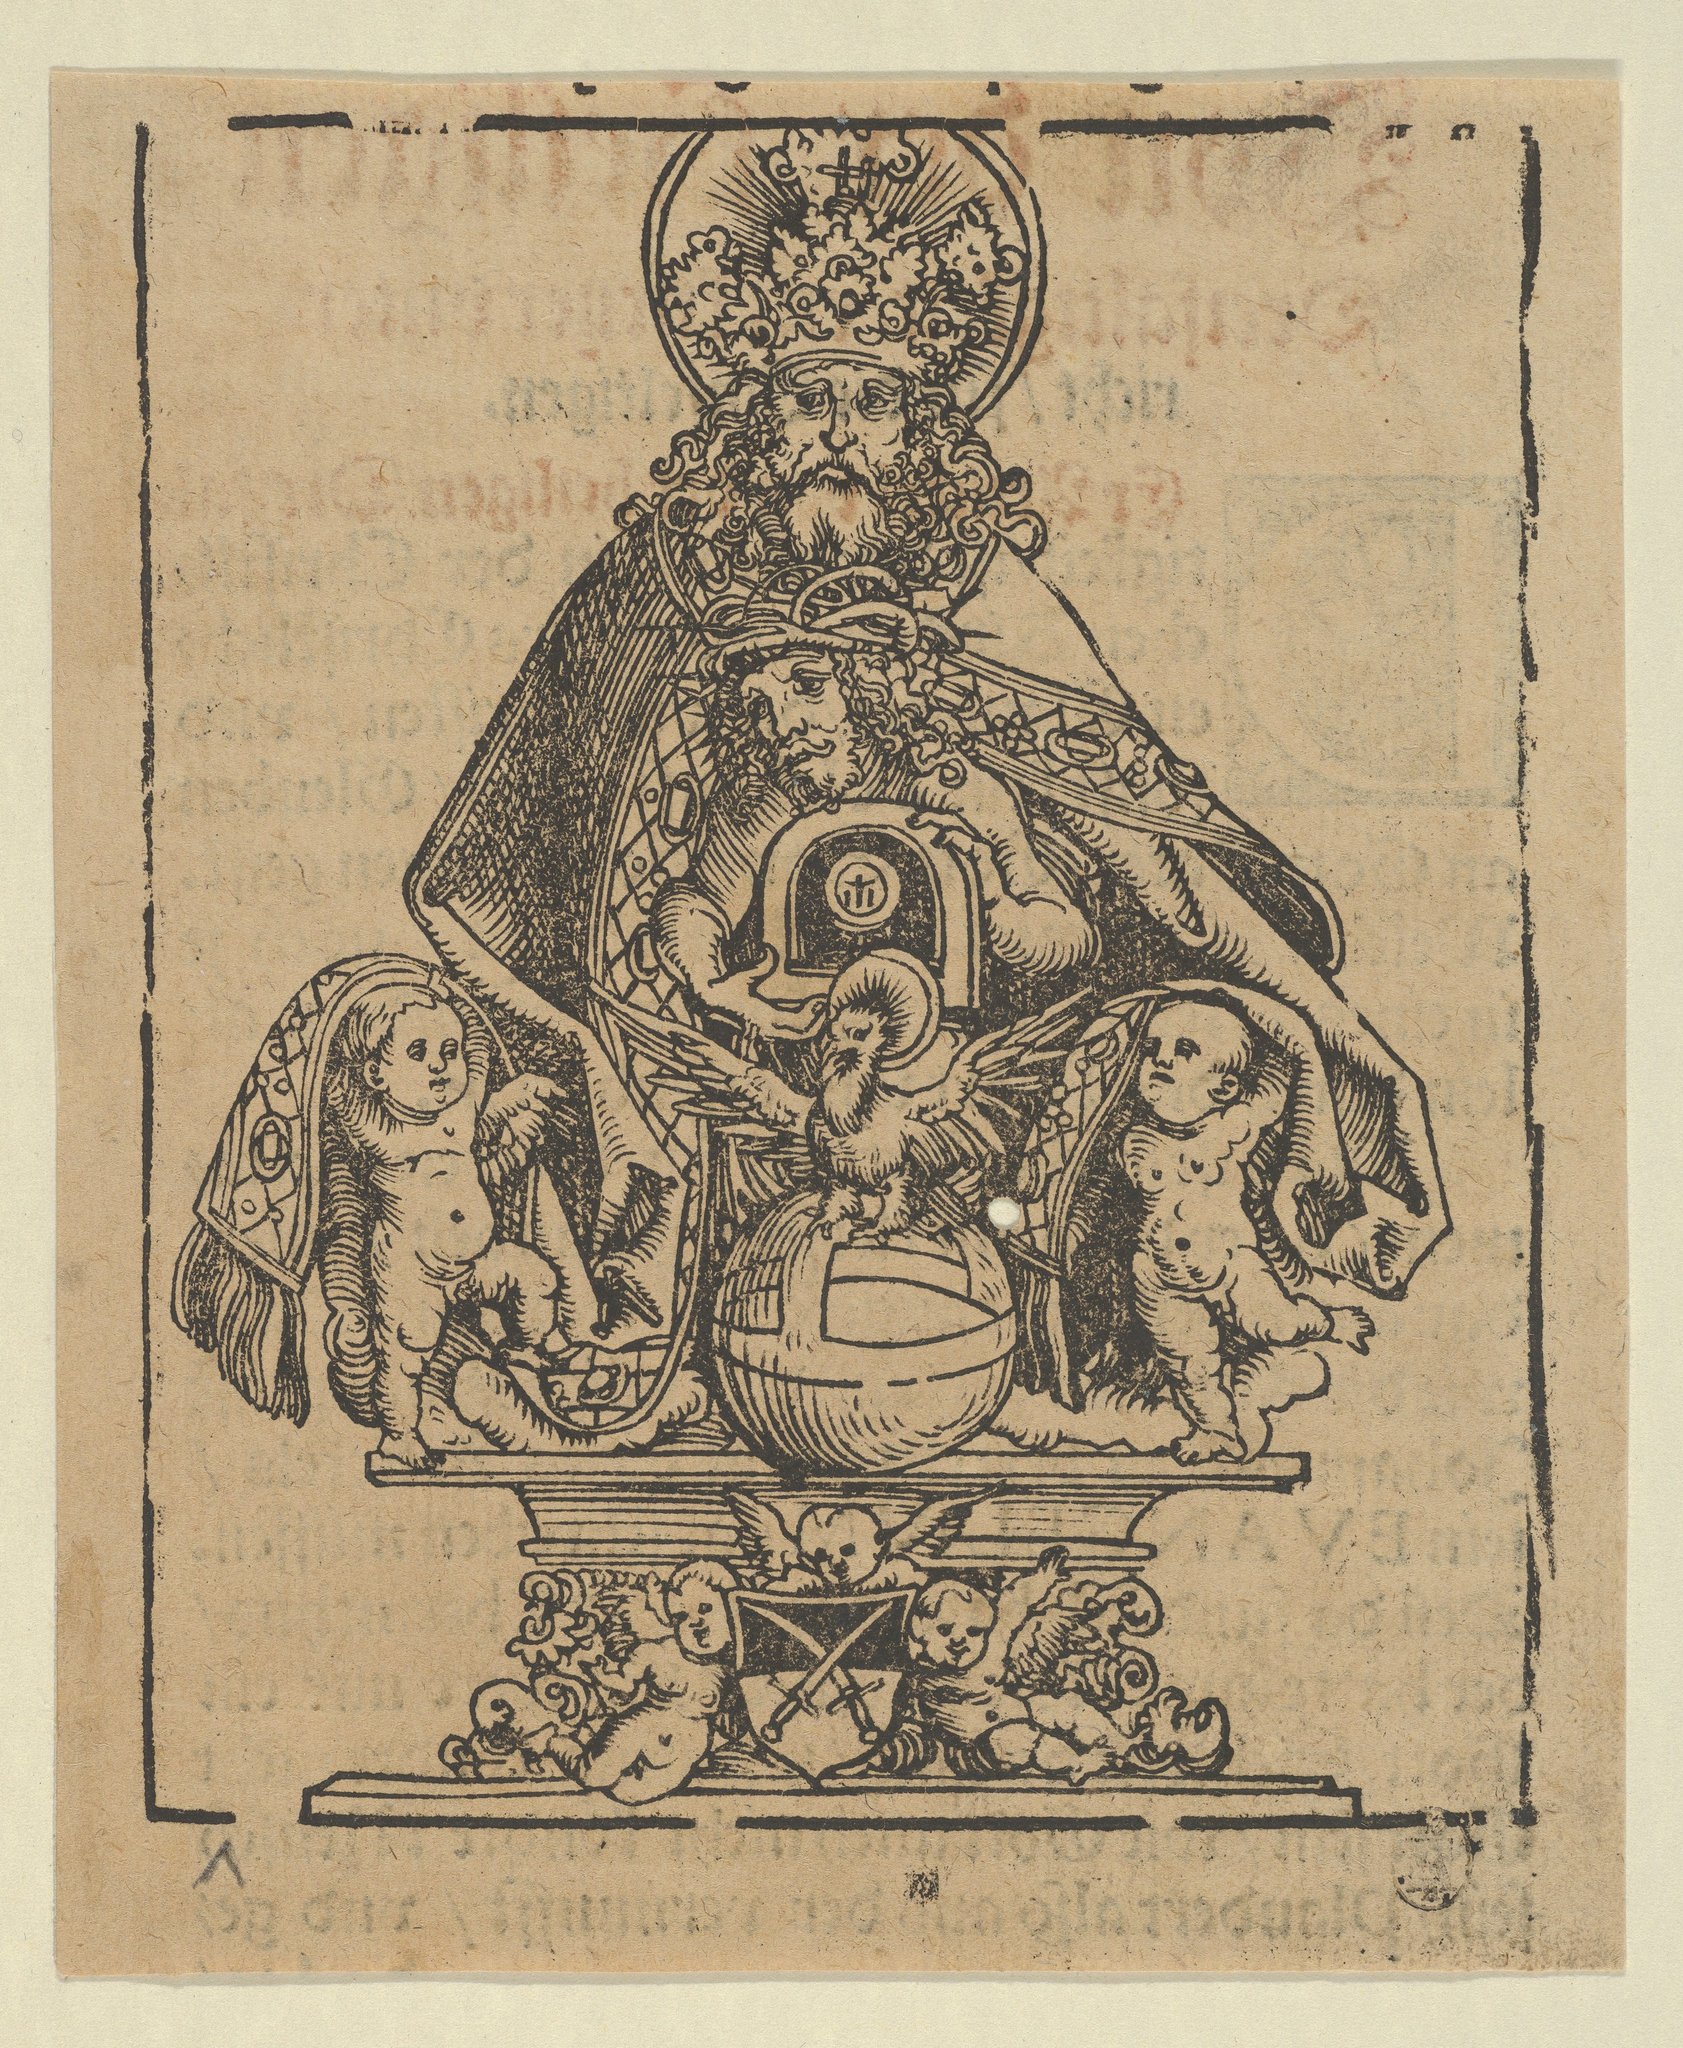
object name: print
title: Reliquary with the Trinity, from "Wittenberg Reliquaries"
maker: lucas cranach the elder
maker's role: artist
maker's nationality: german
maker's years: 1472-1553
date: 1472-1553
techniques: woodcut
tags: putti,christ